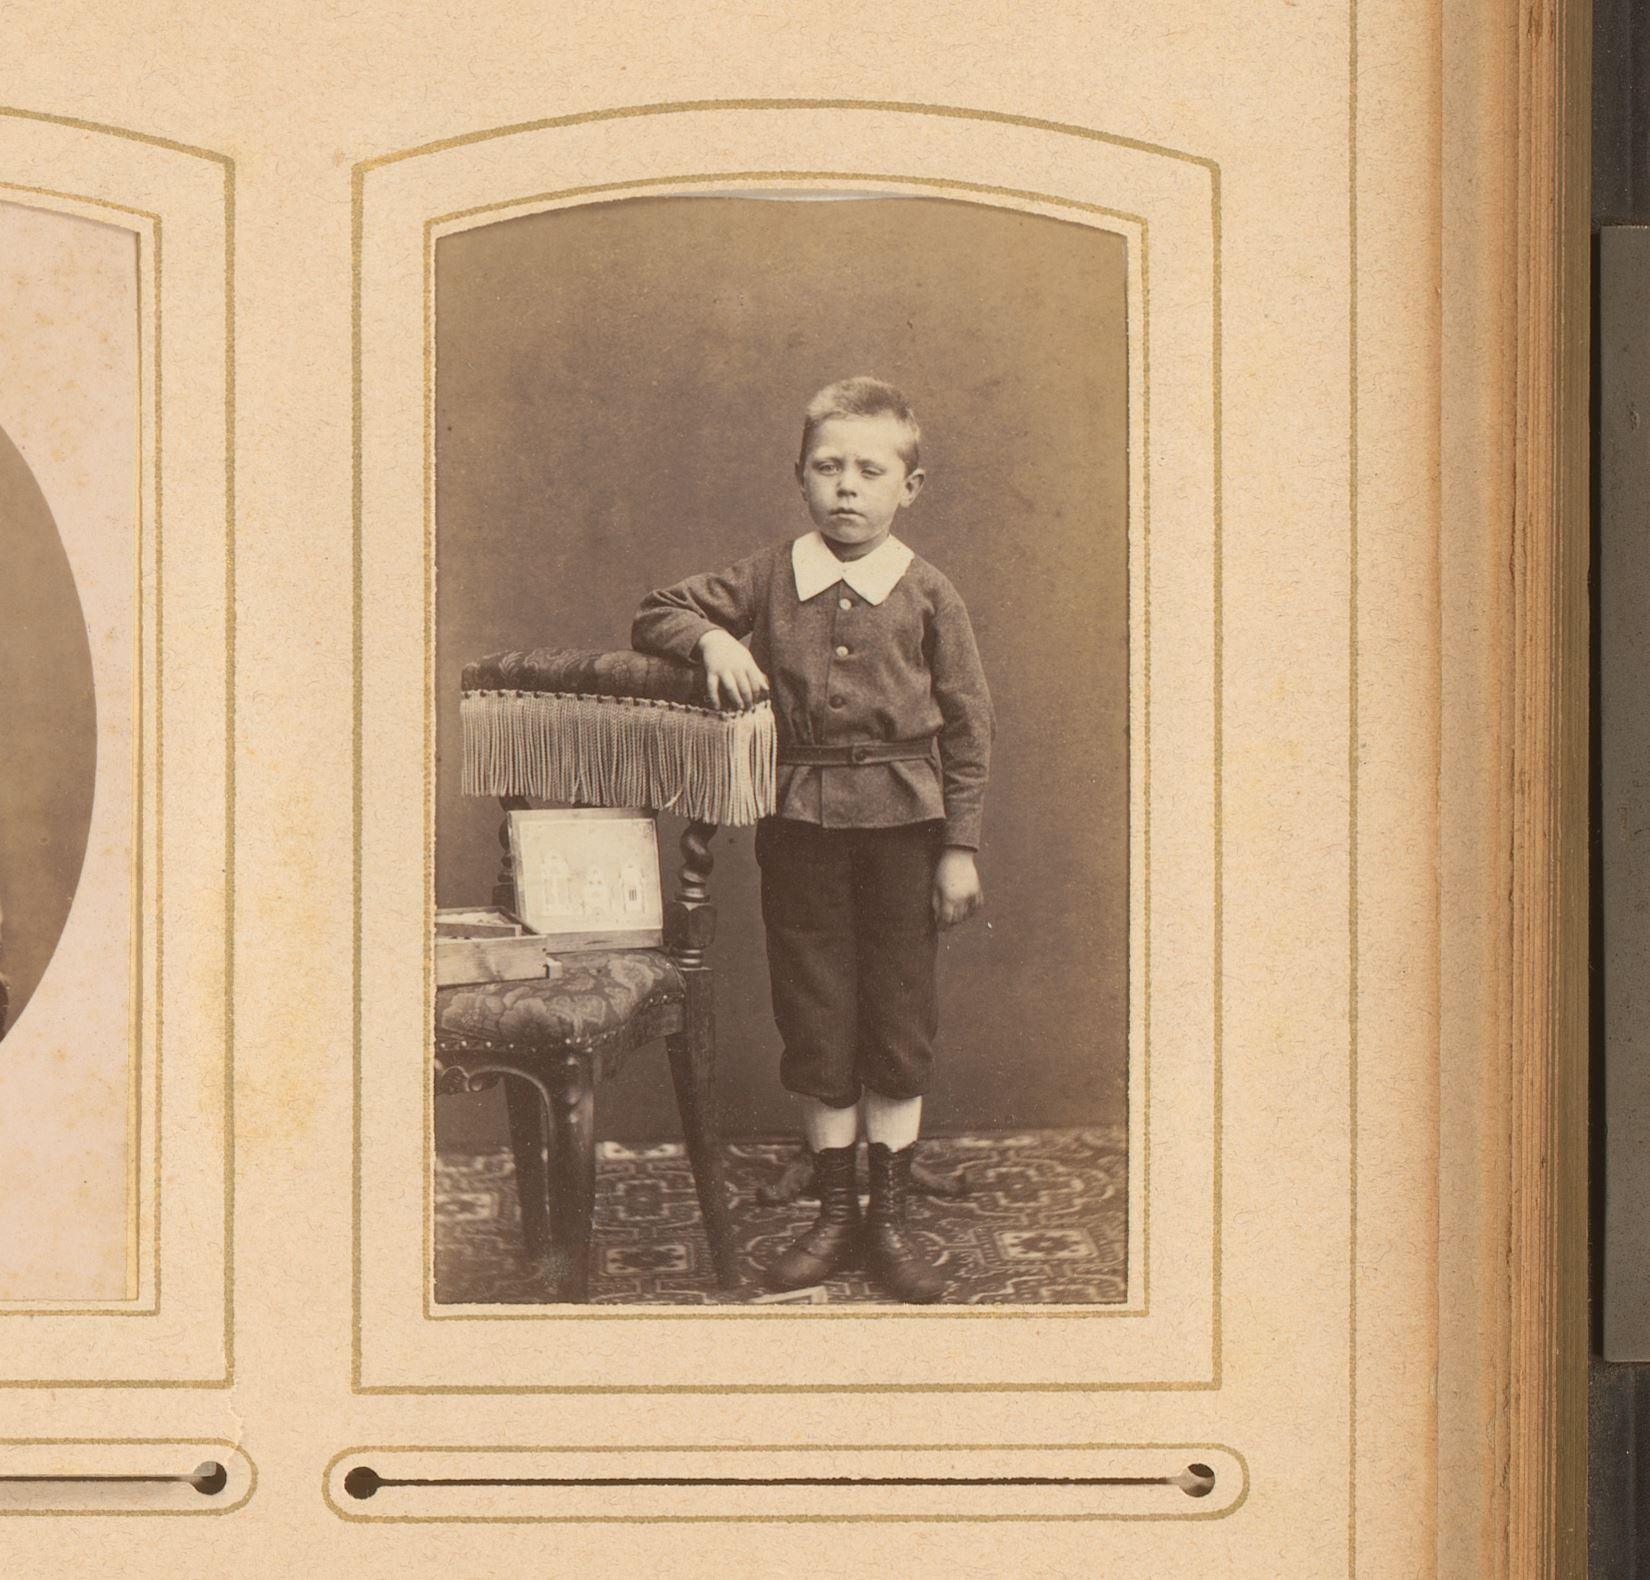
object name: photograph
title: Portret van een jongen, staand bij een stoel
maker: gerrit dirk siewers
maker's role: fotograaf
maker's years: 1846-1899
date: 1871-1891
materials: cardboard, photographic support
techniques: albumen print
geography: hoorn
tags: standing figure, boy (child between toddler and youth), historical persons, chair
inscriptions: inscription: ‘G D. Siewers/ Photographe/ HOORN./ ADRES: C. VAN WIJK, STALHOUDER./ Achter de groote Kerk./ De negatieven blijven bewaard tot nabestelling’